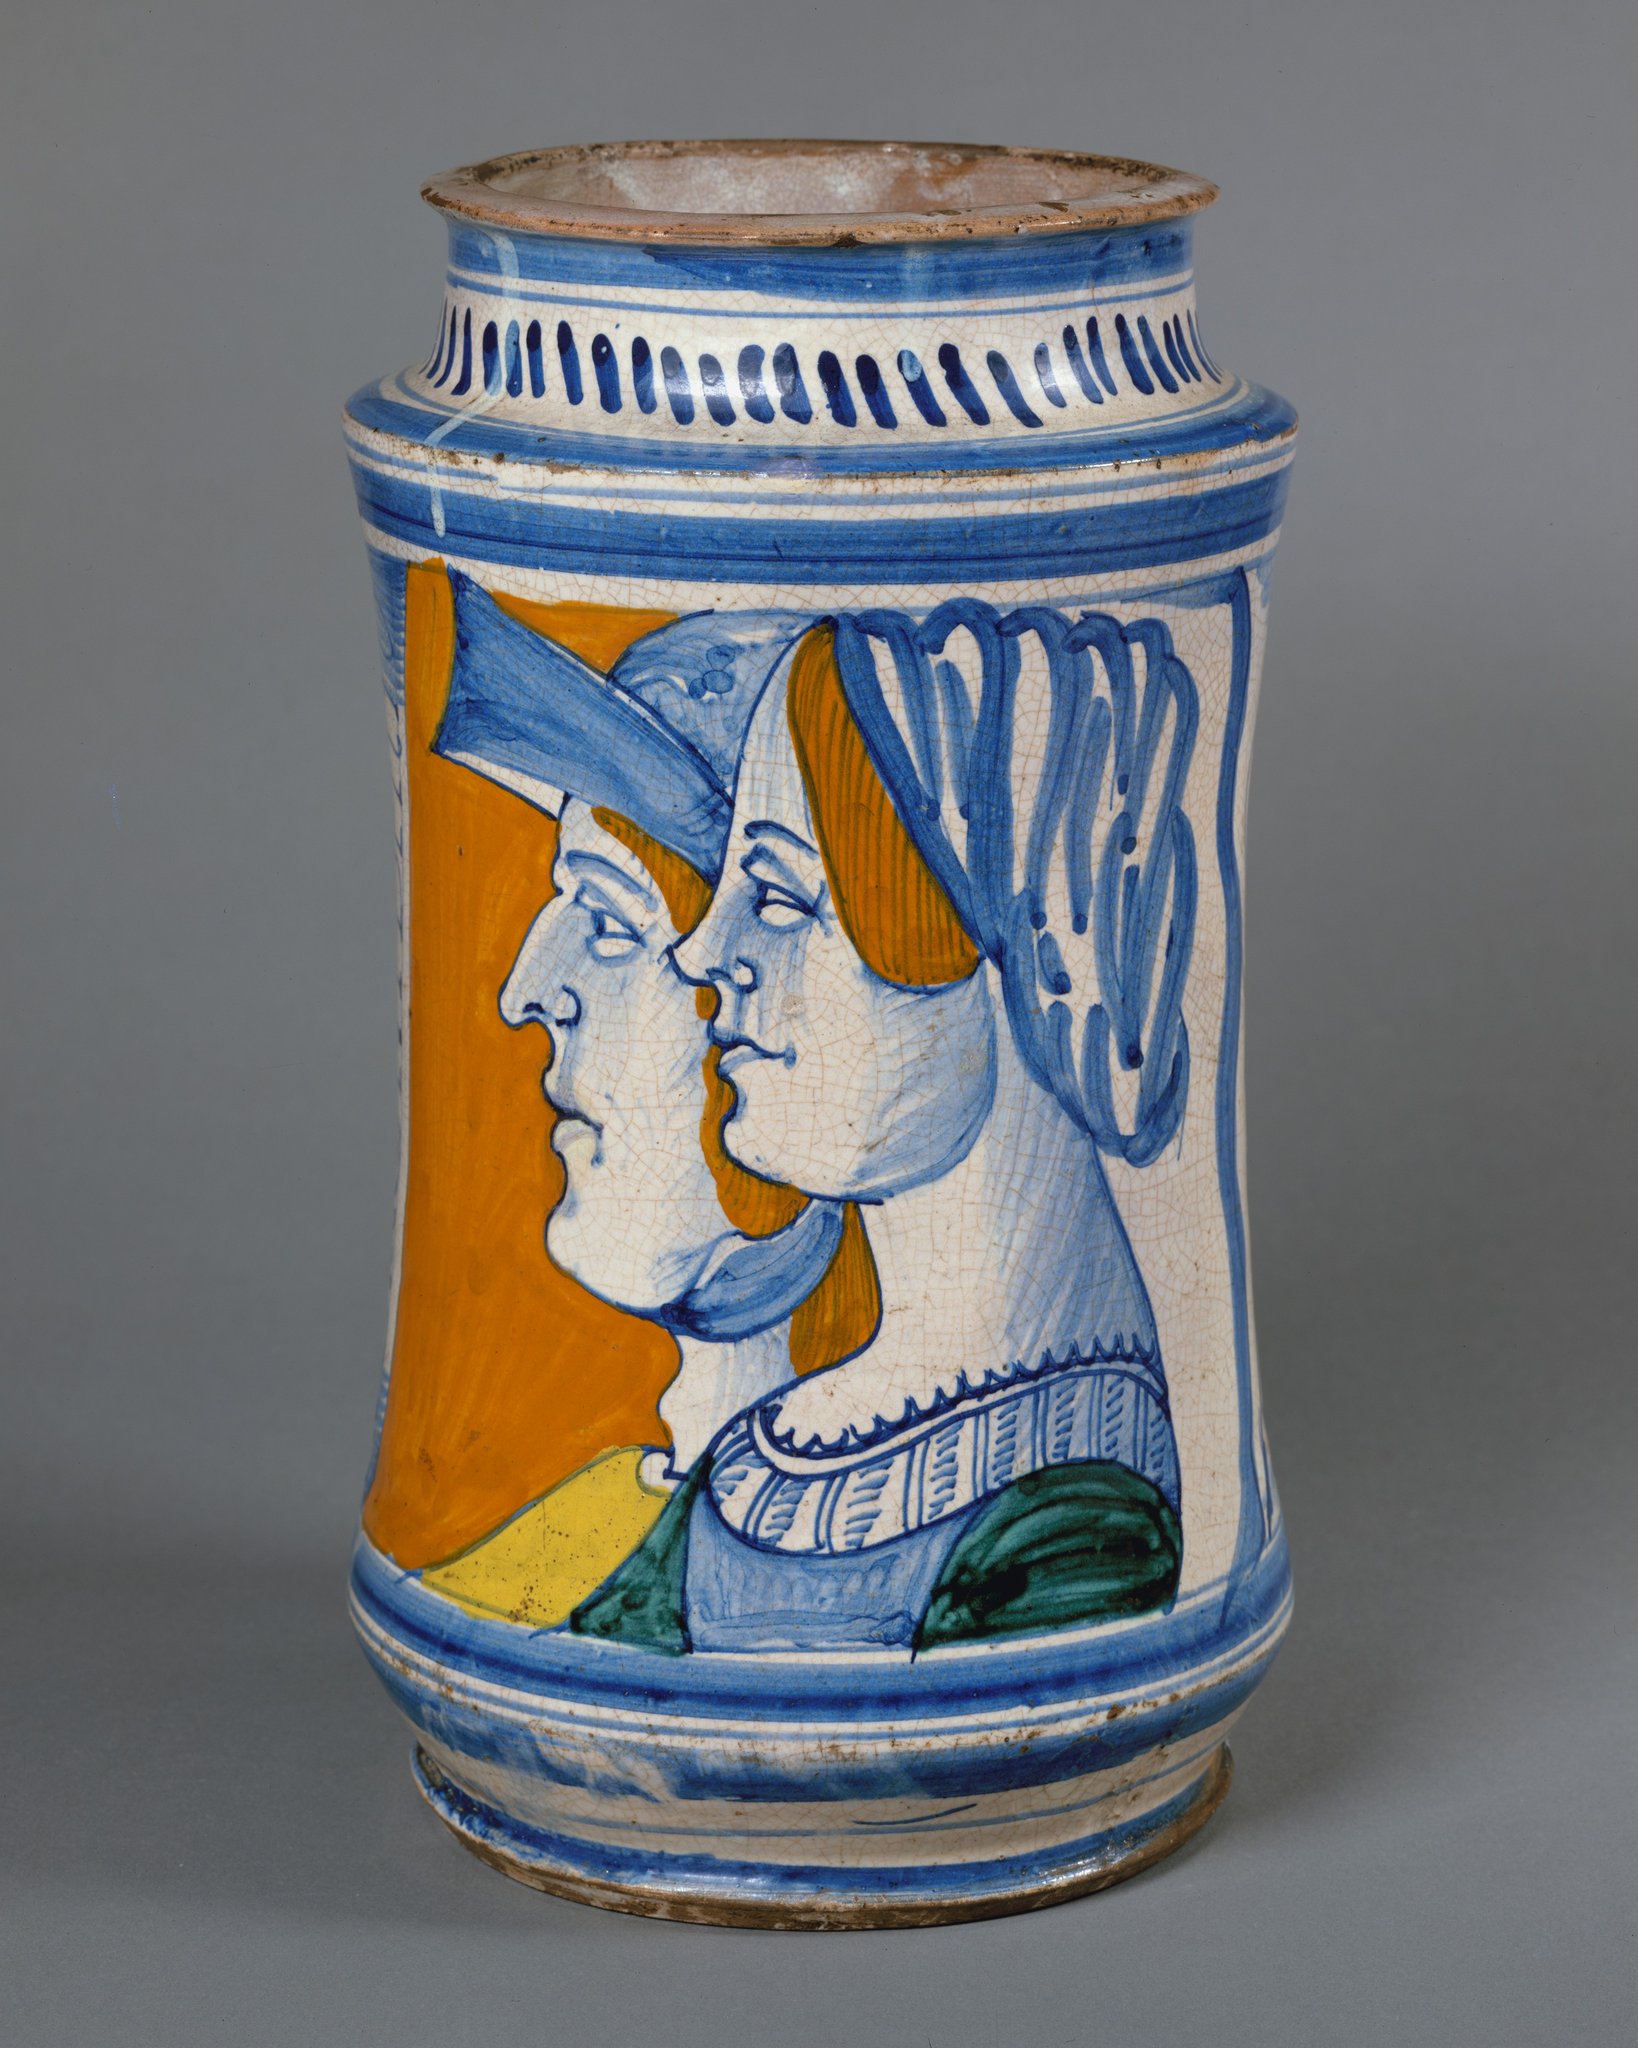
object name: albarello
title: Apothecary jar (albarello)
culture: italian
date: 1480-1500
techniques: maiolica, glazing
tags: men,profiles,women